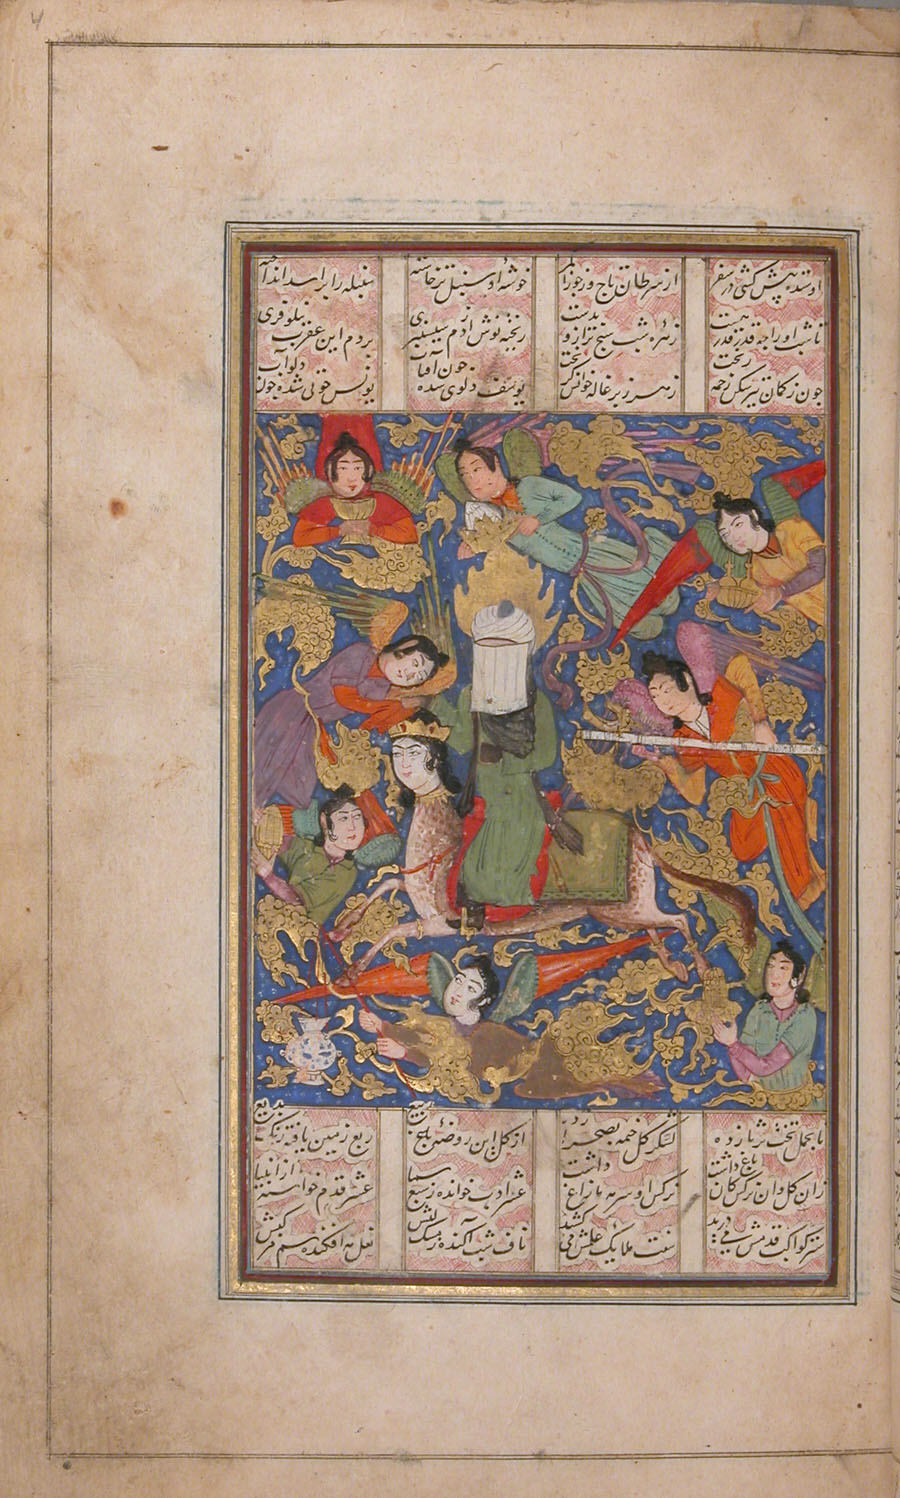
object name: illustrated manuscript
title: Khamsa (Quintet) of Nizami of Ganja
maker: nizami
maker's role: author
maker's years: 1141-1209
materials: leather, paper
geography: iran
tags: men,hunting,horses